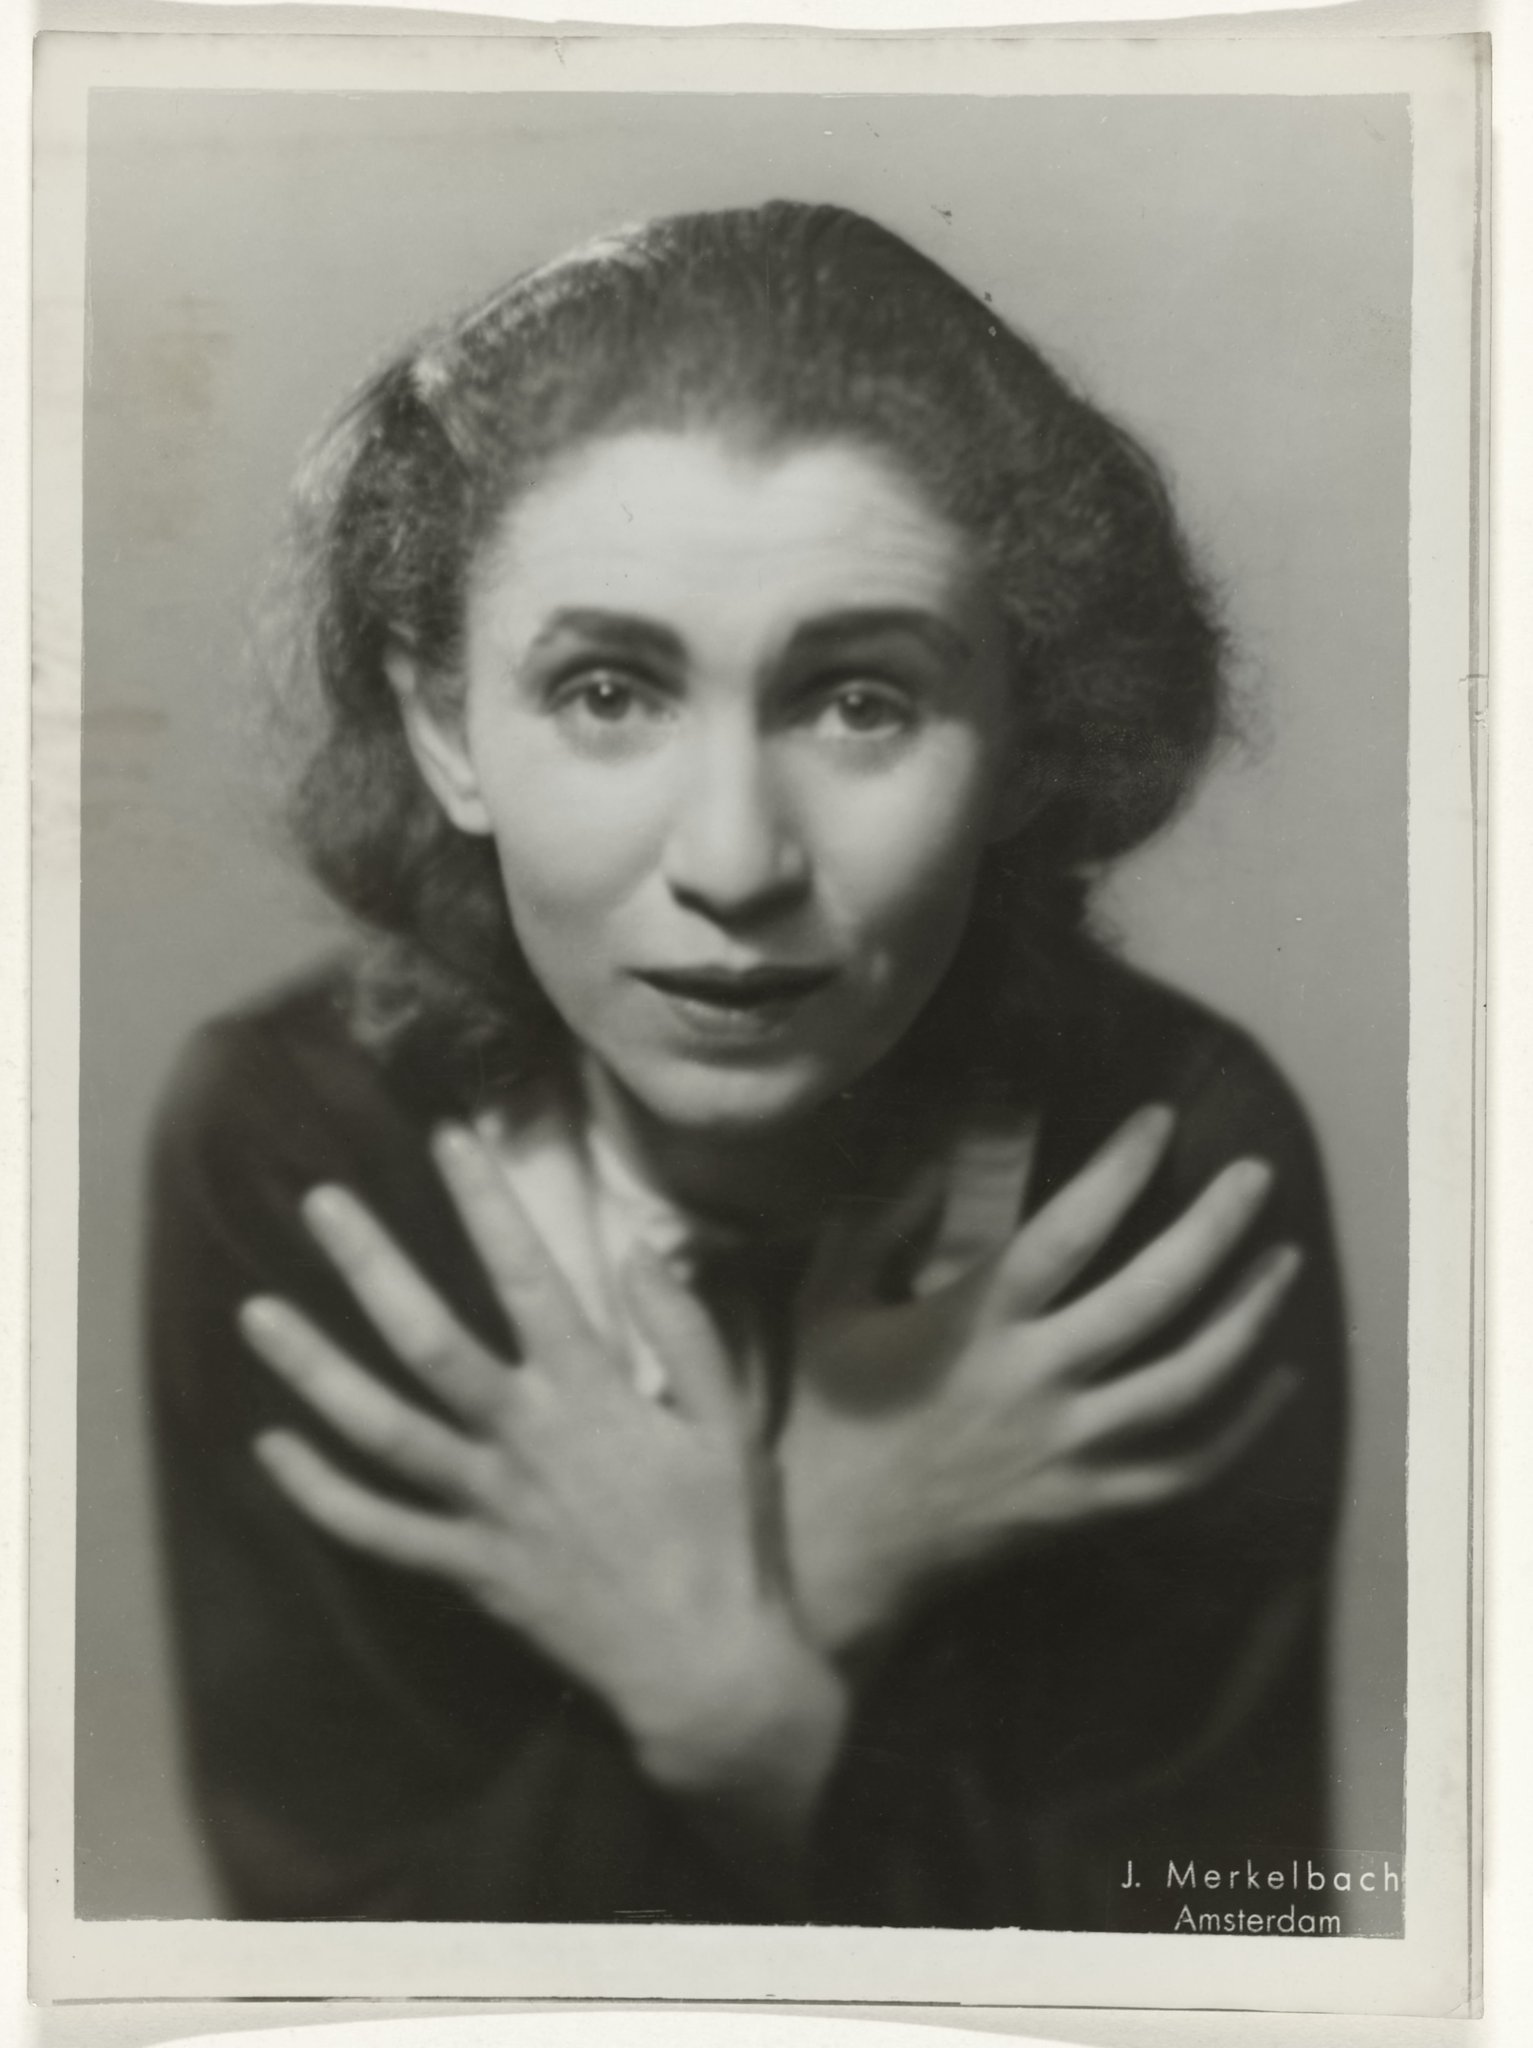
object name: photograph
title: Portret van Chaja Goldstein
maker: jacob merkelbach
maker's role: fotograaf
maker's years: 1877-1942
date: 1890-1942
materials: photographic support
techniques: gelatin silver print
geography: amsterdam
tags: portrait of artiste (dancer, actor, etc.), historical persons - bb - woman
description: Frontaal portret van vrouw met gekruiste armen voor borst.